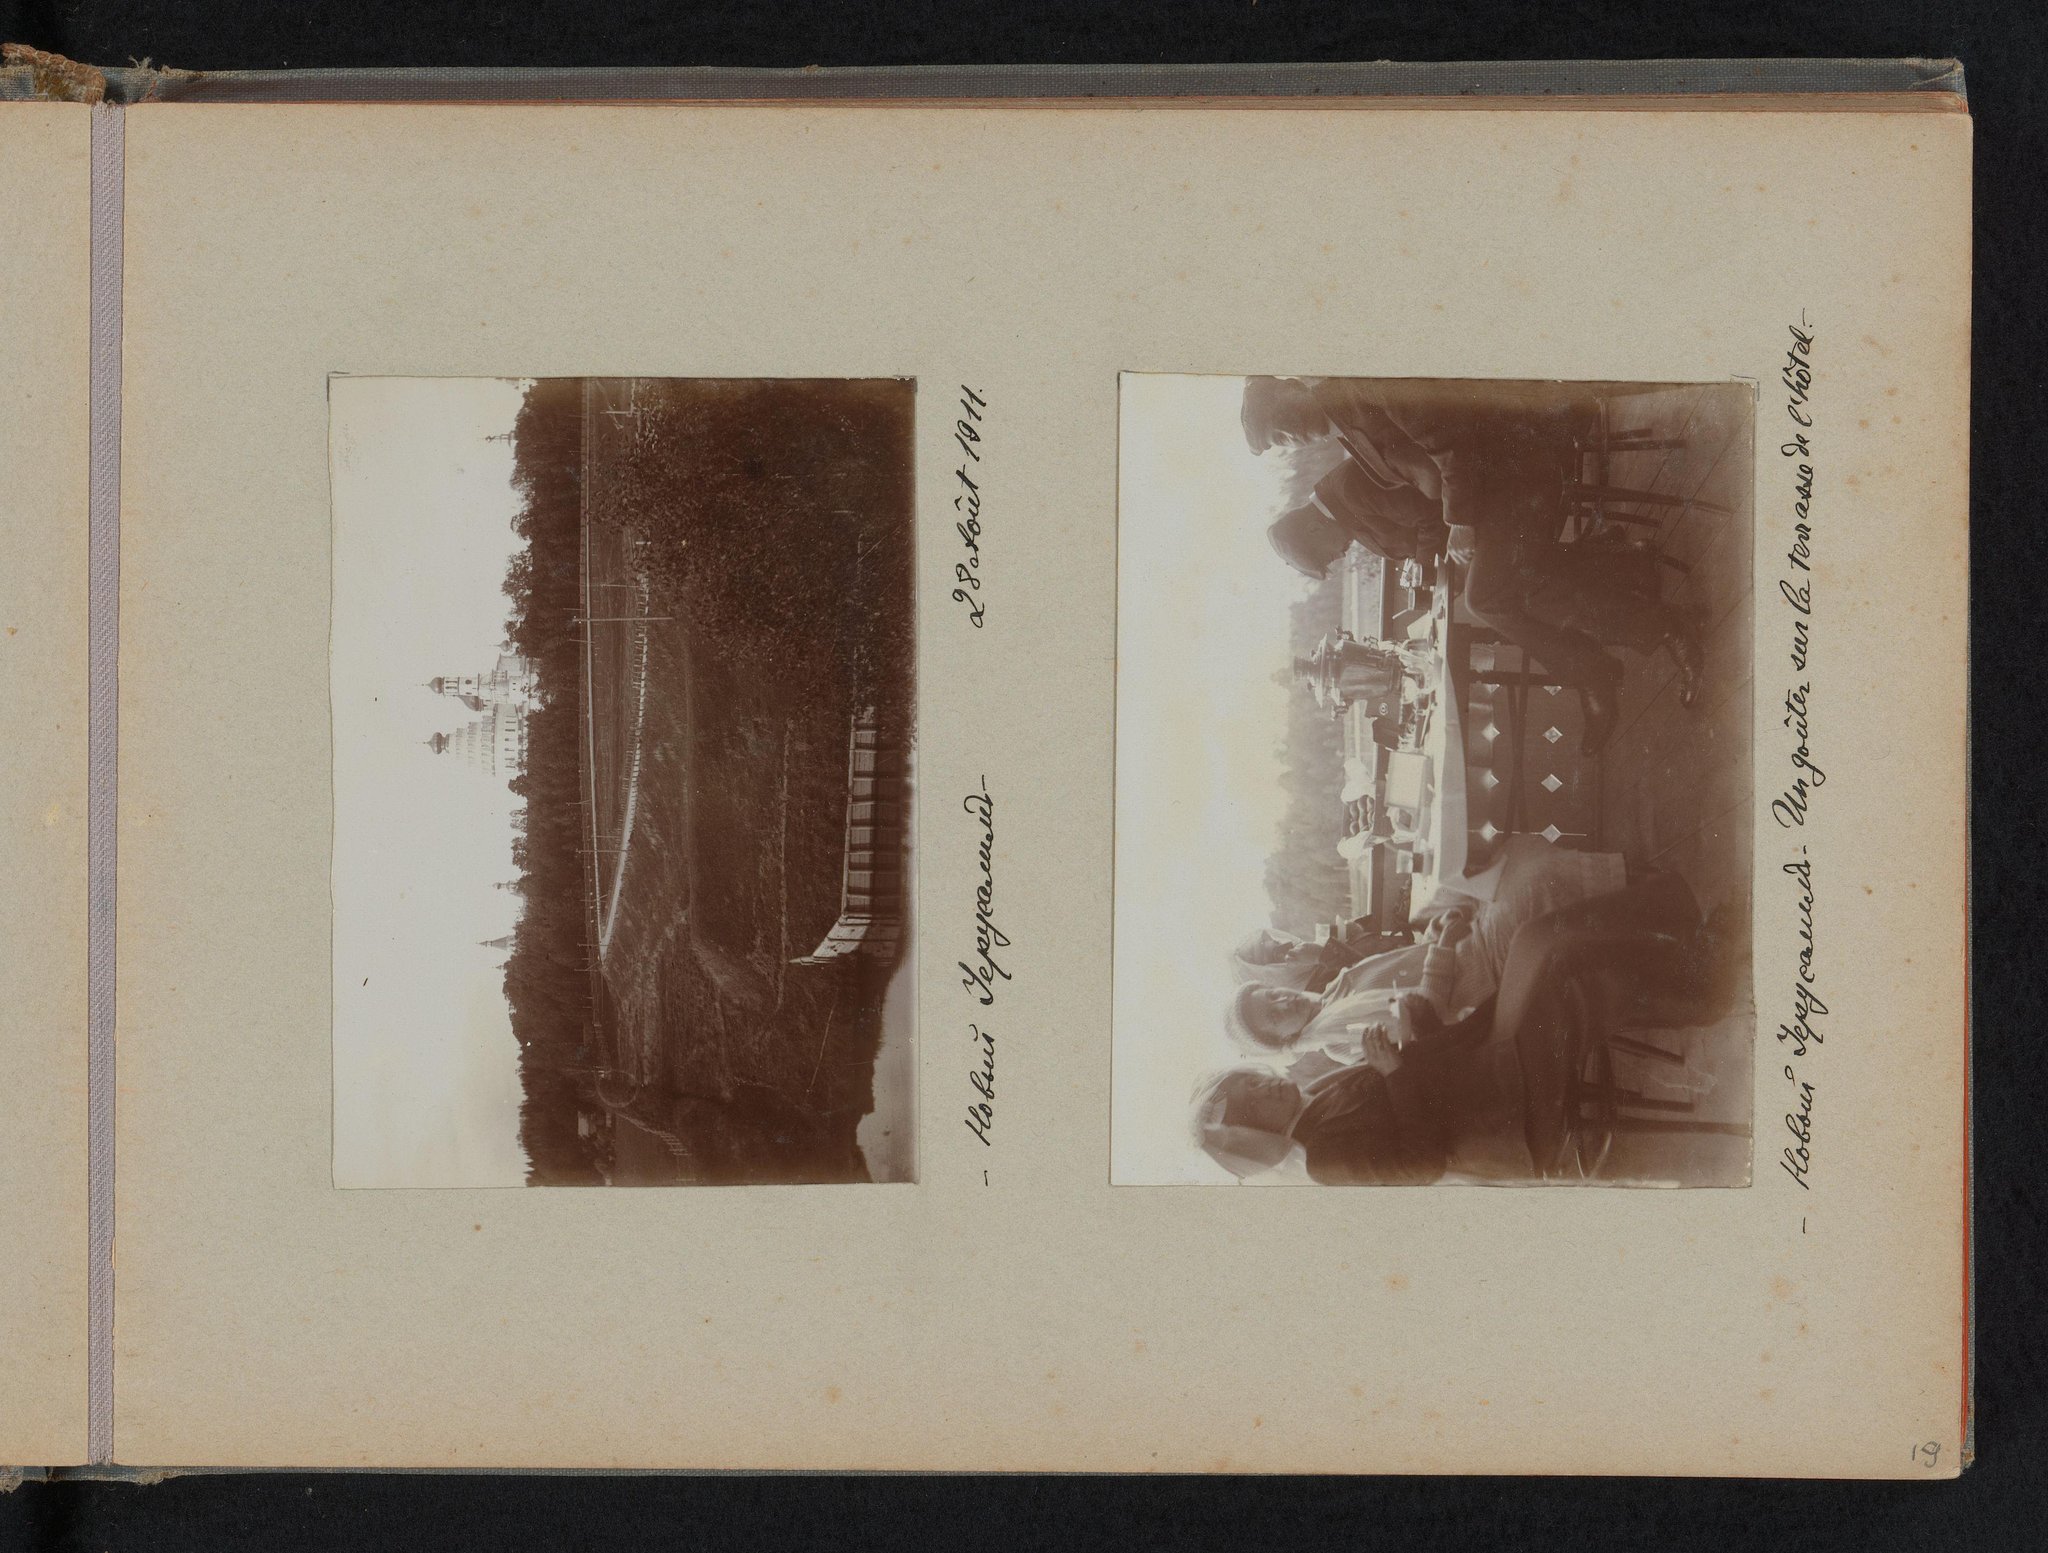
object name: photograph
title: Gezicht op een hotel en mensen op het terras van het hotel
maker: Anonymous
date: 1911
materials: paper, cardboard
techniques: collodion silver print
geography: russia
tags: historical persons, terrace, hotel, hostelry, inn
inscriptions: inscription: ‘- [...] - Un goûter sur la terrasse de l'hôtel.-’, inscription: ‘- [...] - 28 août. 1911’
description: Deze foto's maken deel uit van een album.